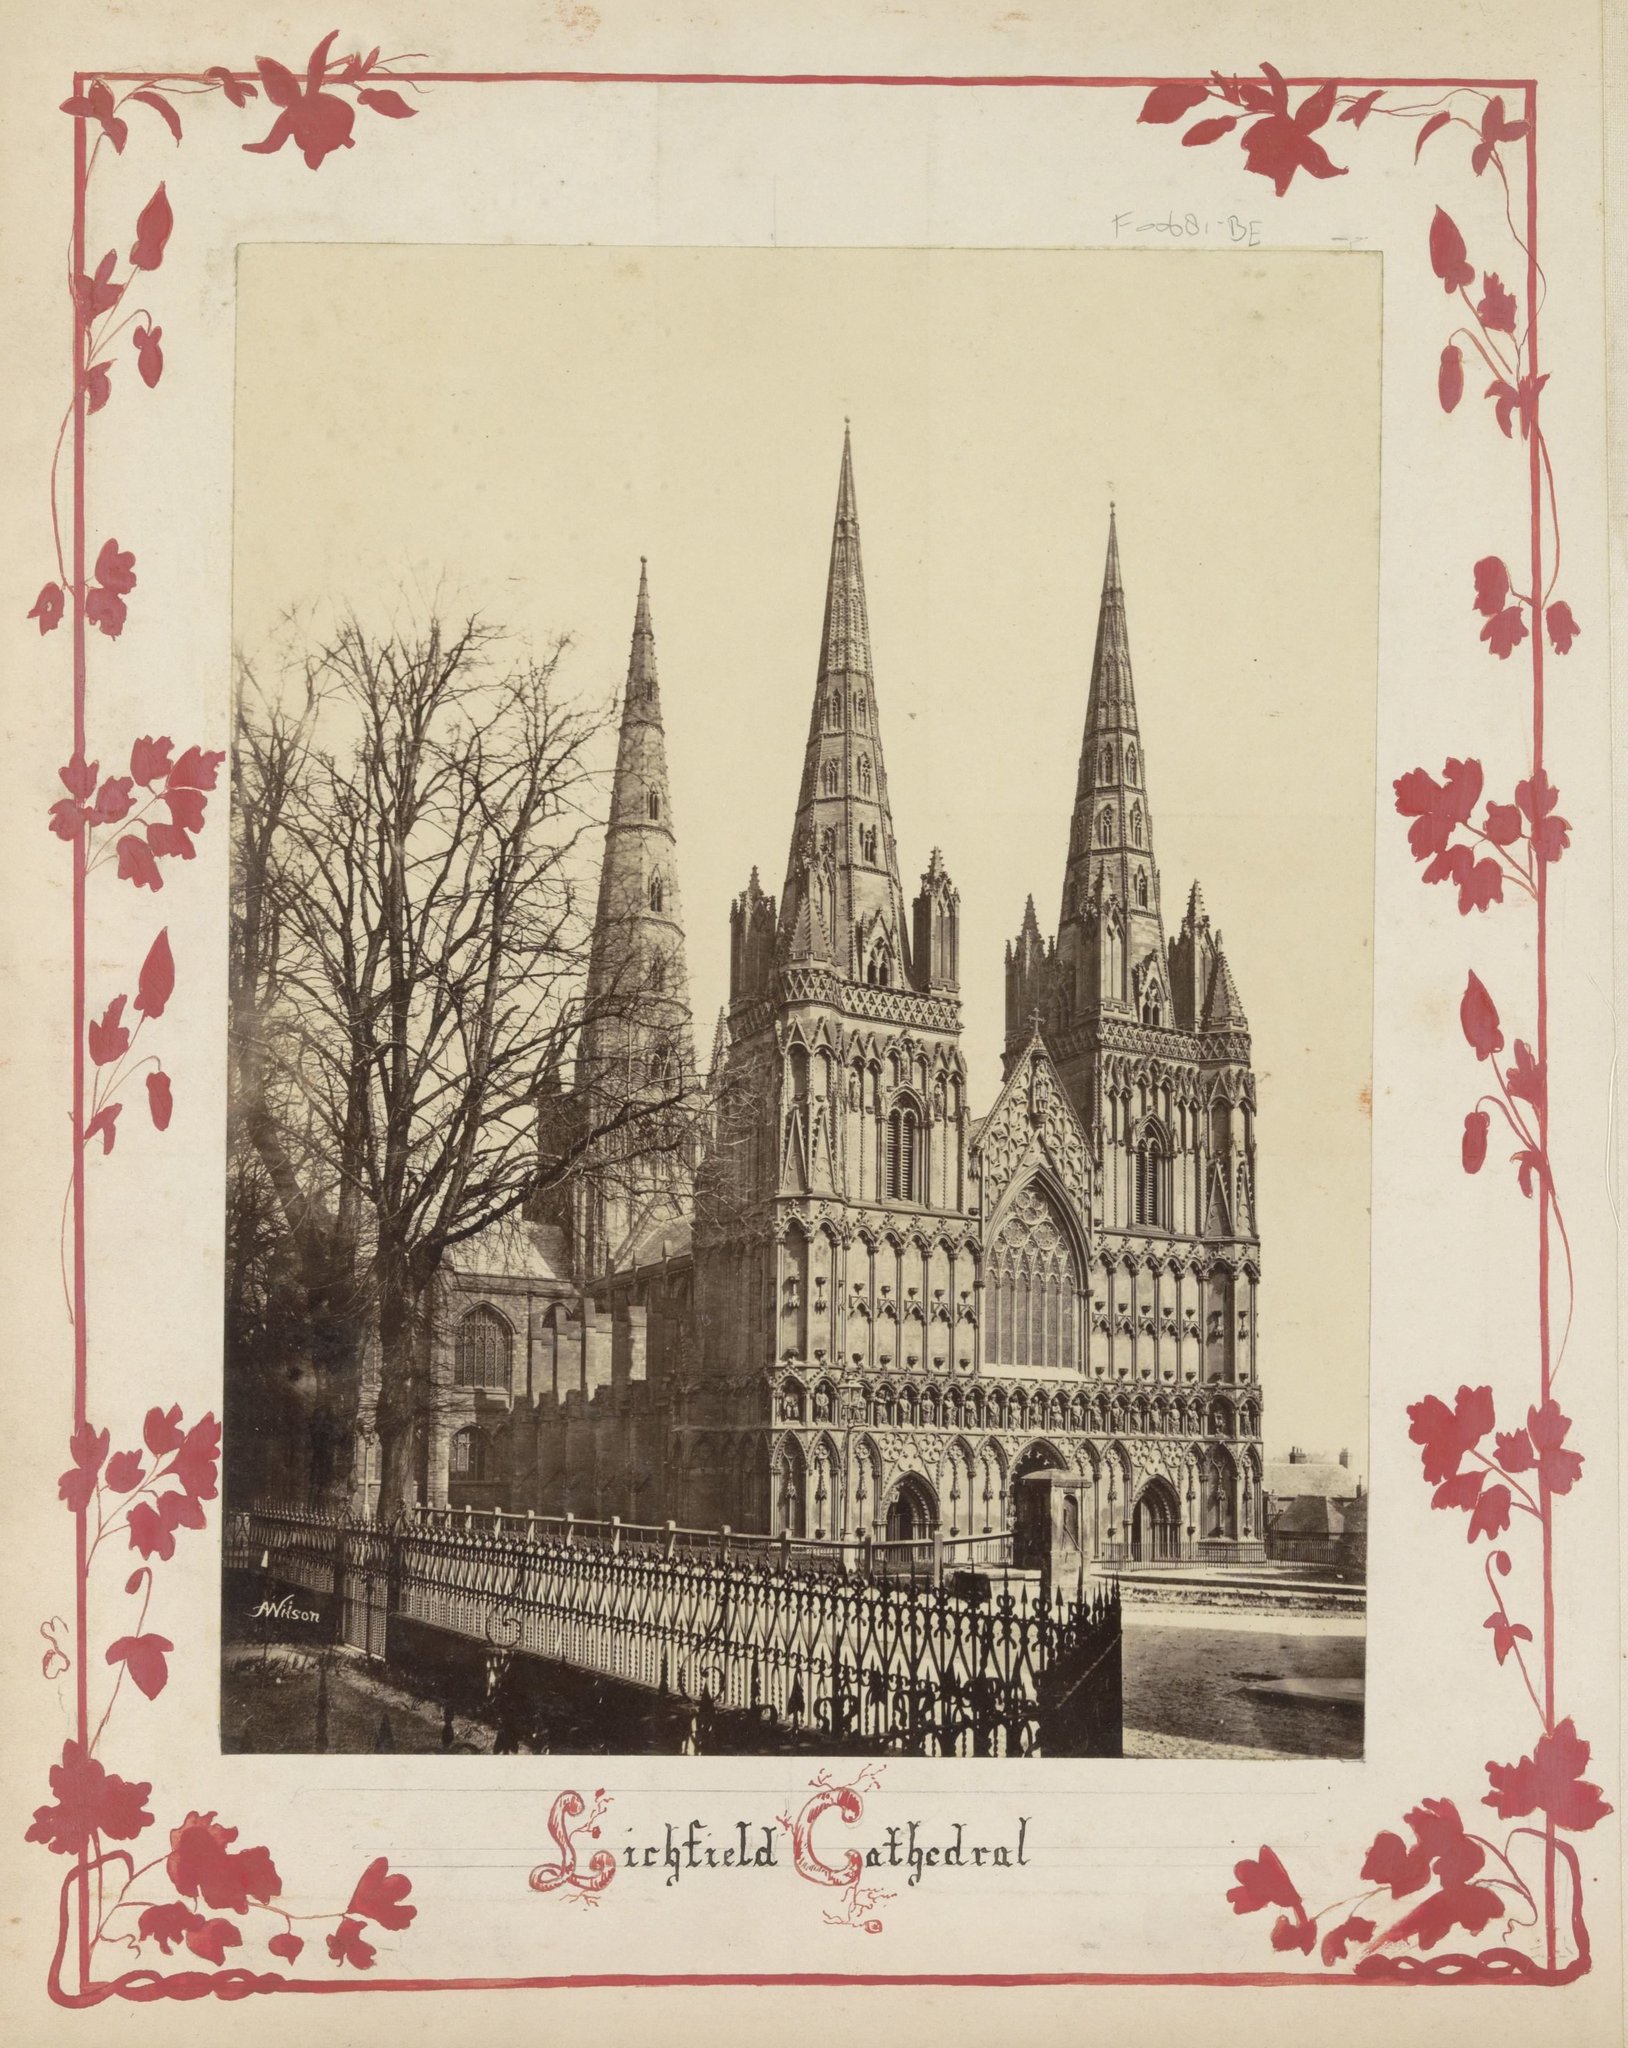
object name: photograph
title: Lichfield Cathedral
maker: a. nilson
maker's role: fotograaf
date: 1850-1870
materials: paper, photographic support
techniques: albumen print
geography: lichfield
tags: church (exterior), parts of church exterior and annexes: tower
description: Onderdeel van Album met foto's van bezienswaardigheden en landschappen in Engeland en van kunst.